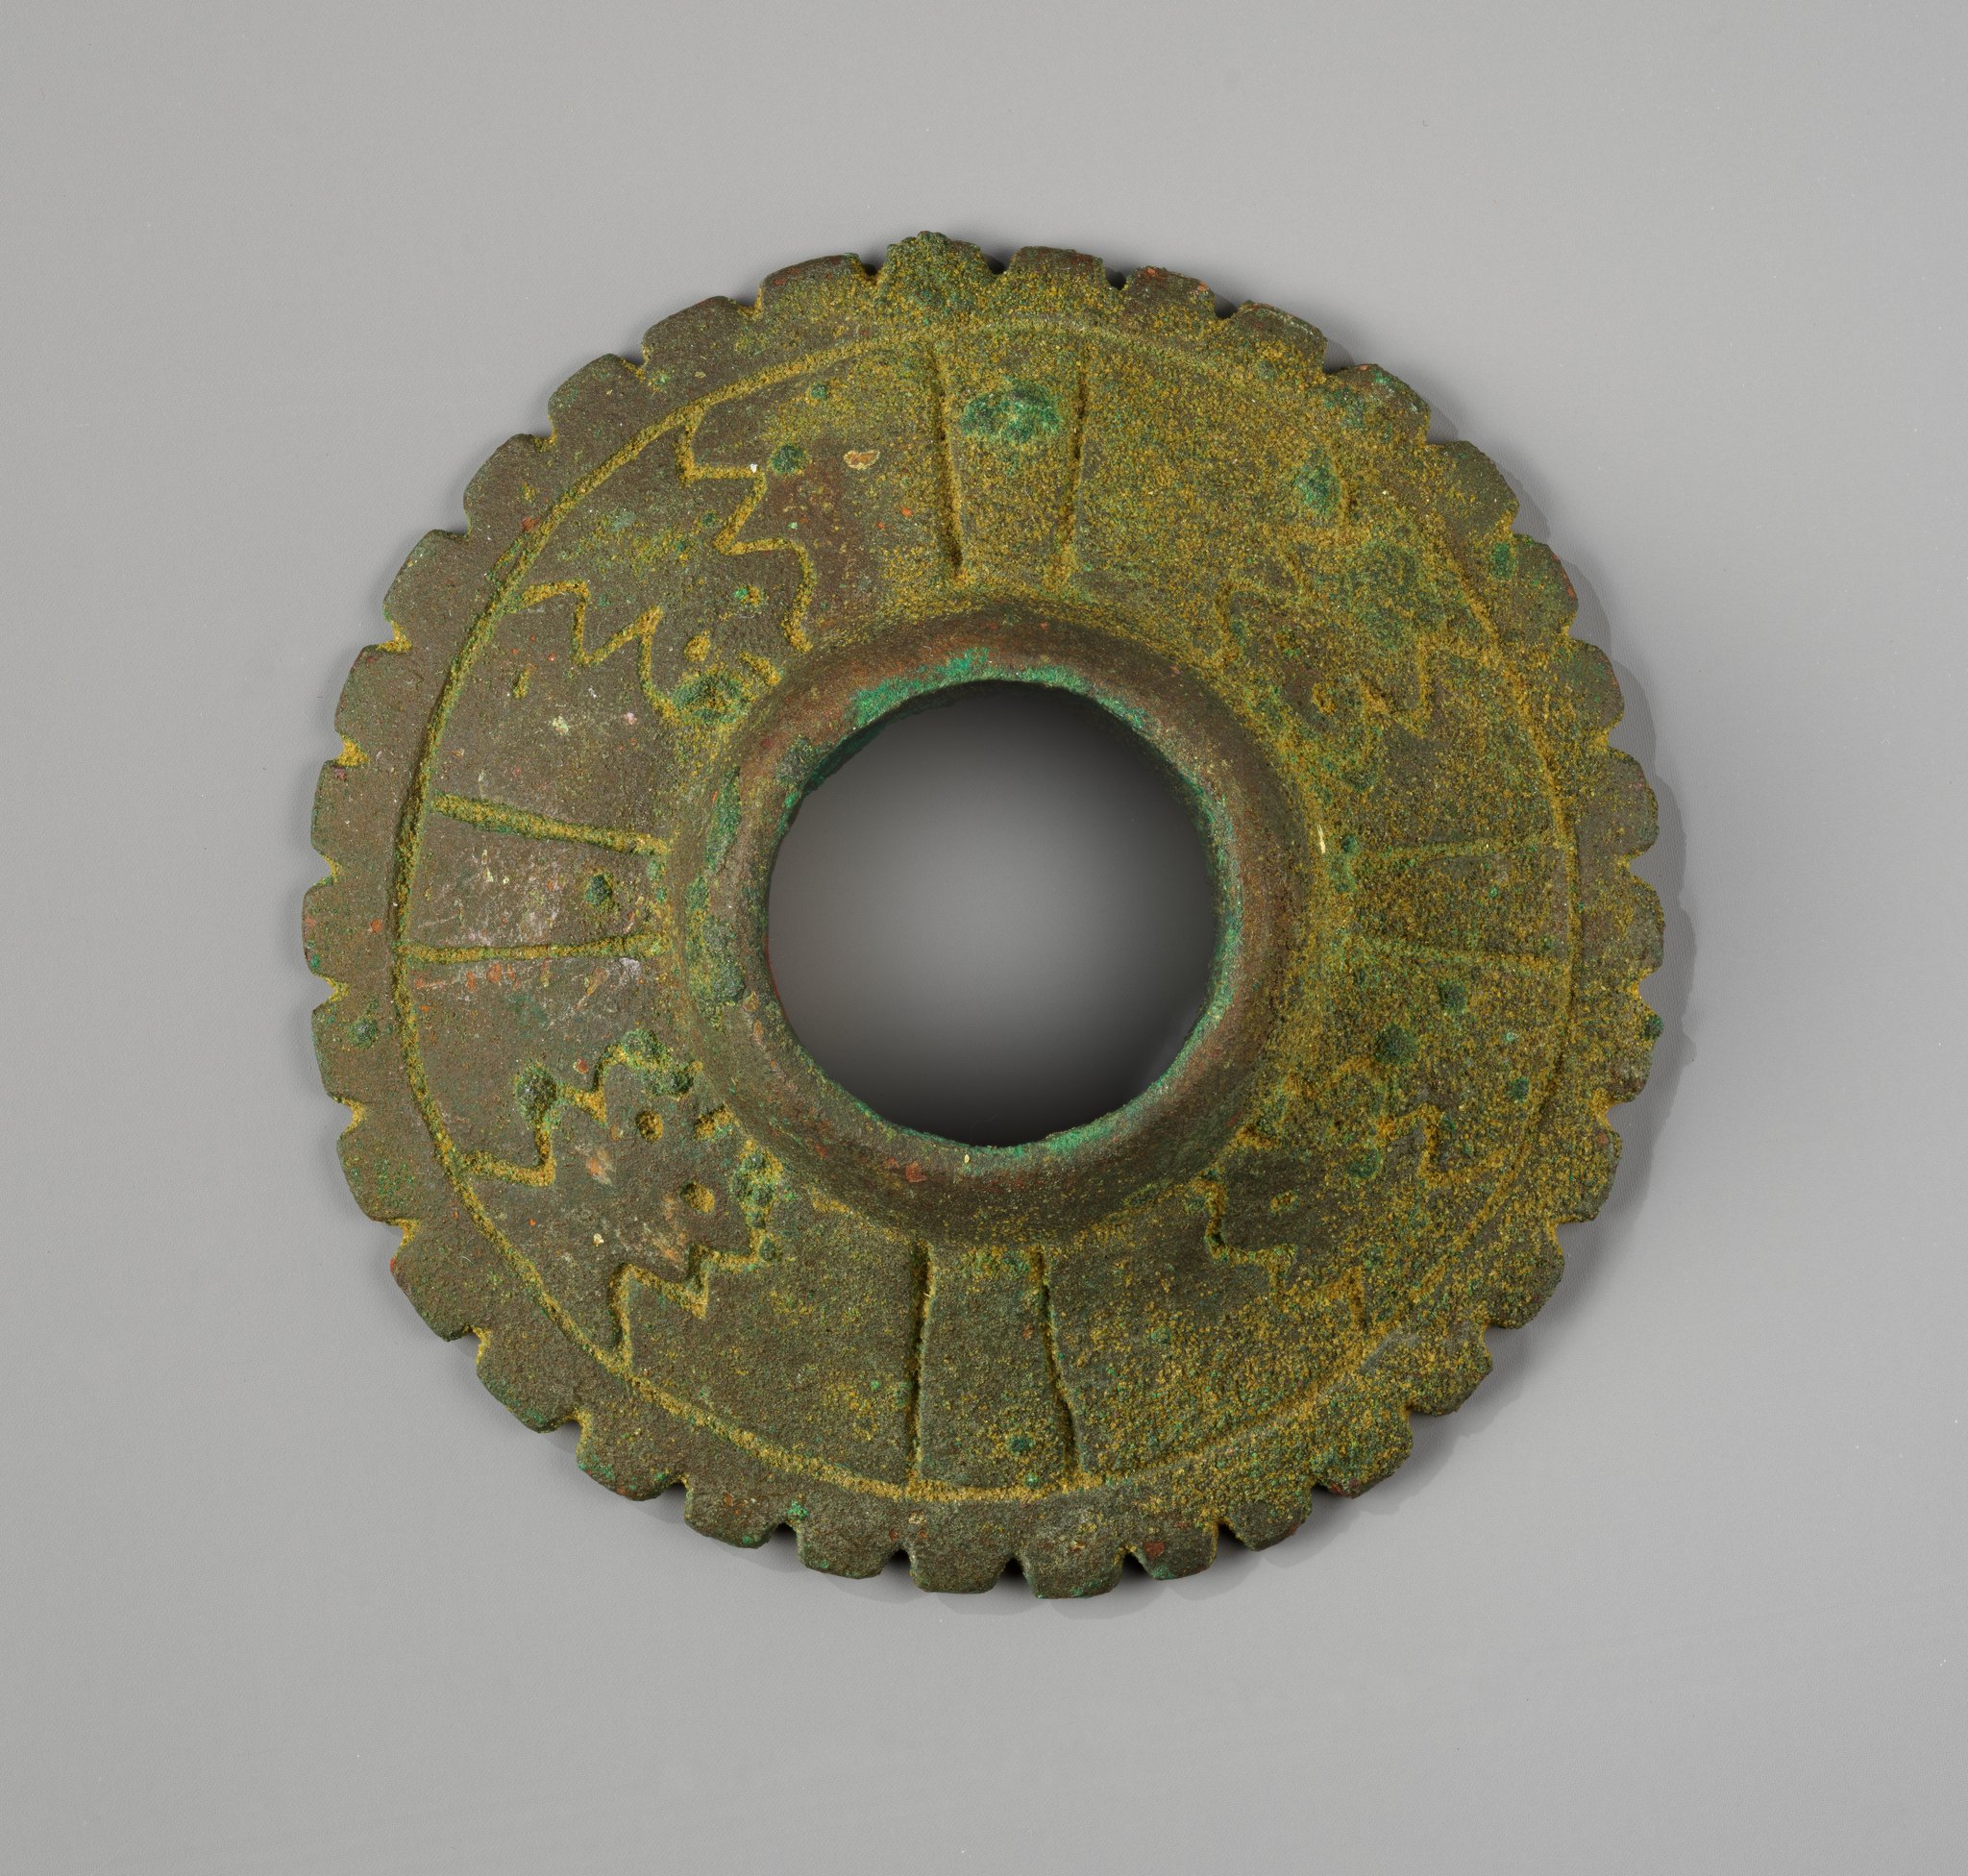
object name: mace head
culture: vicús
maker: vicús artist(s)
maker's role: artist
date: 100 BCE-500 CE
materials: copper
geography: peru